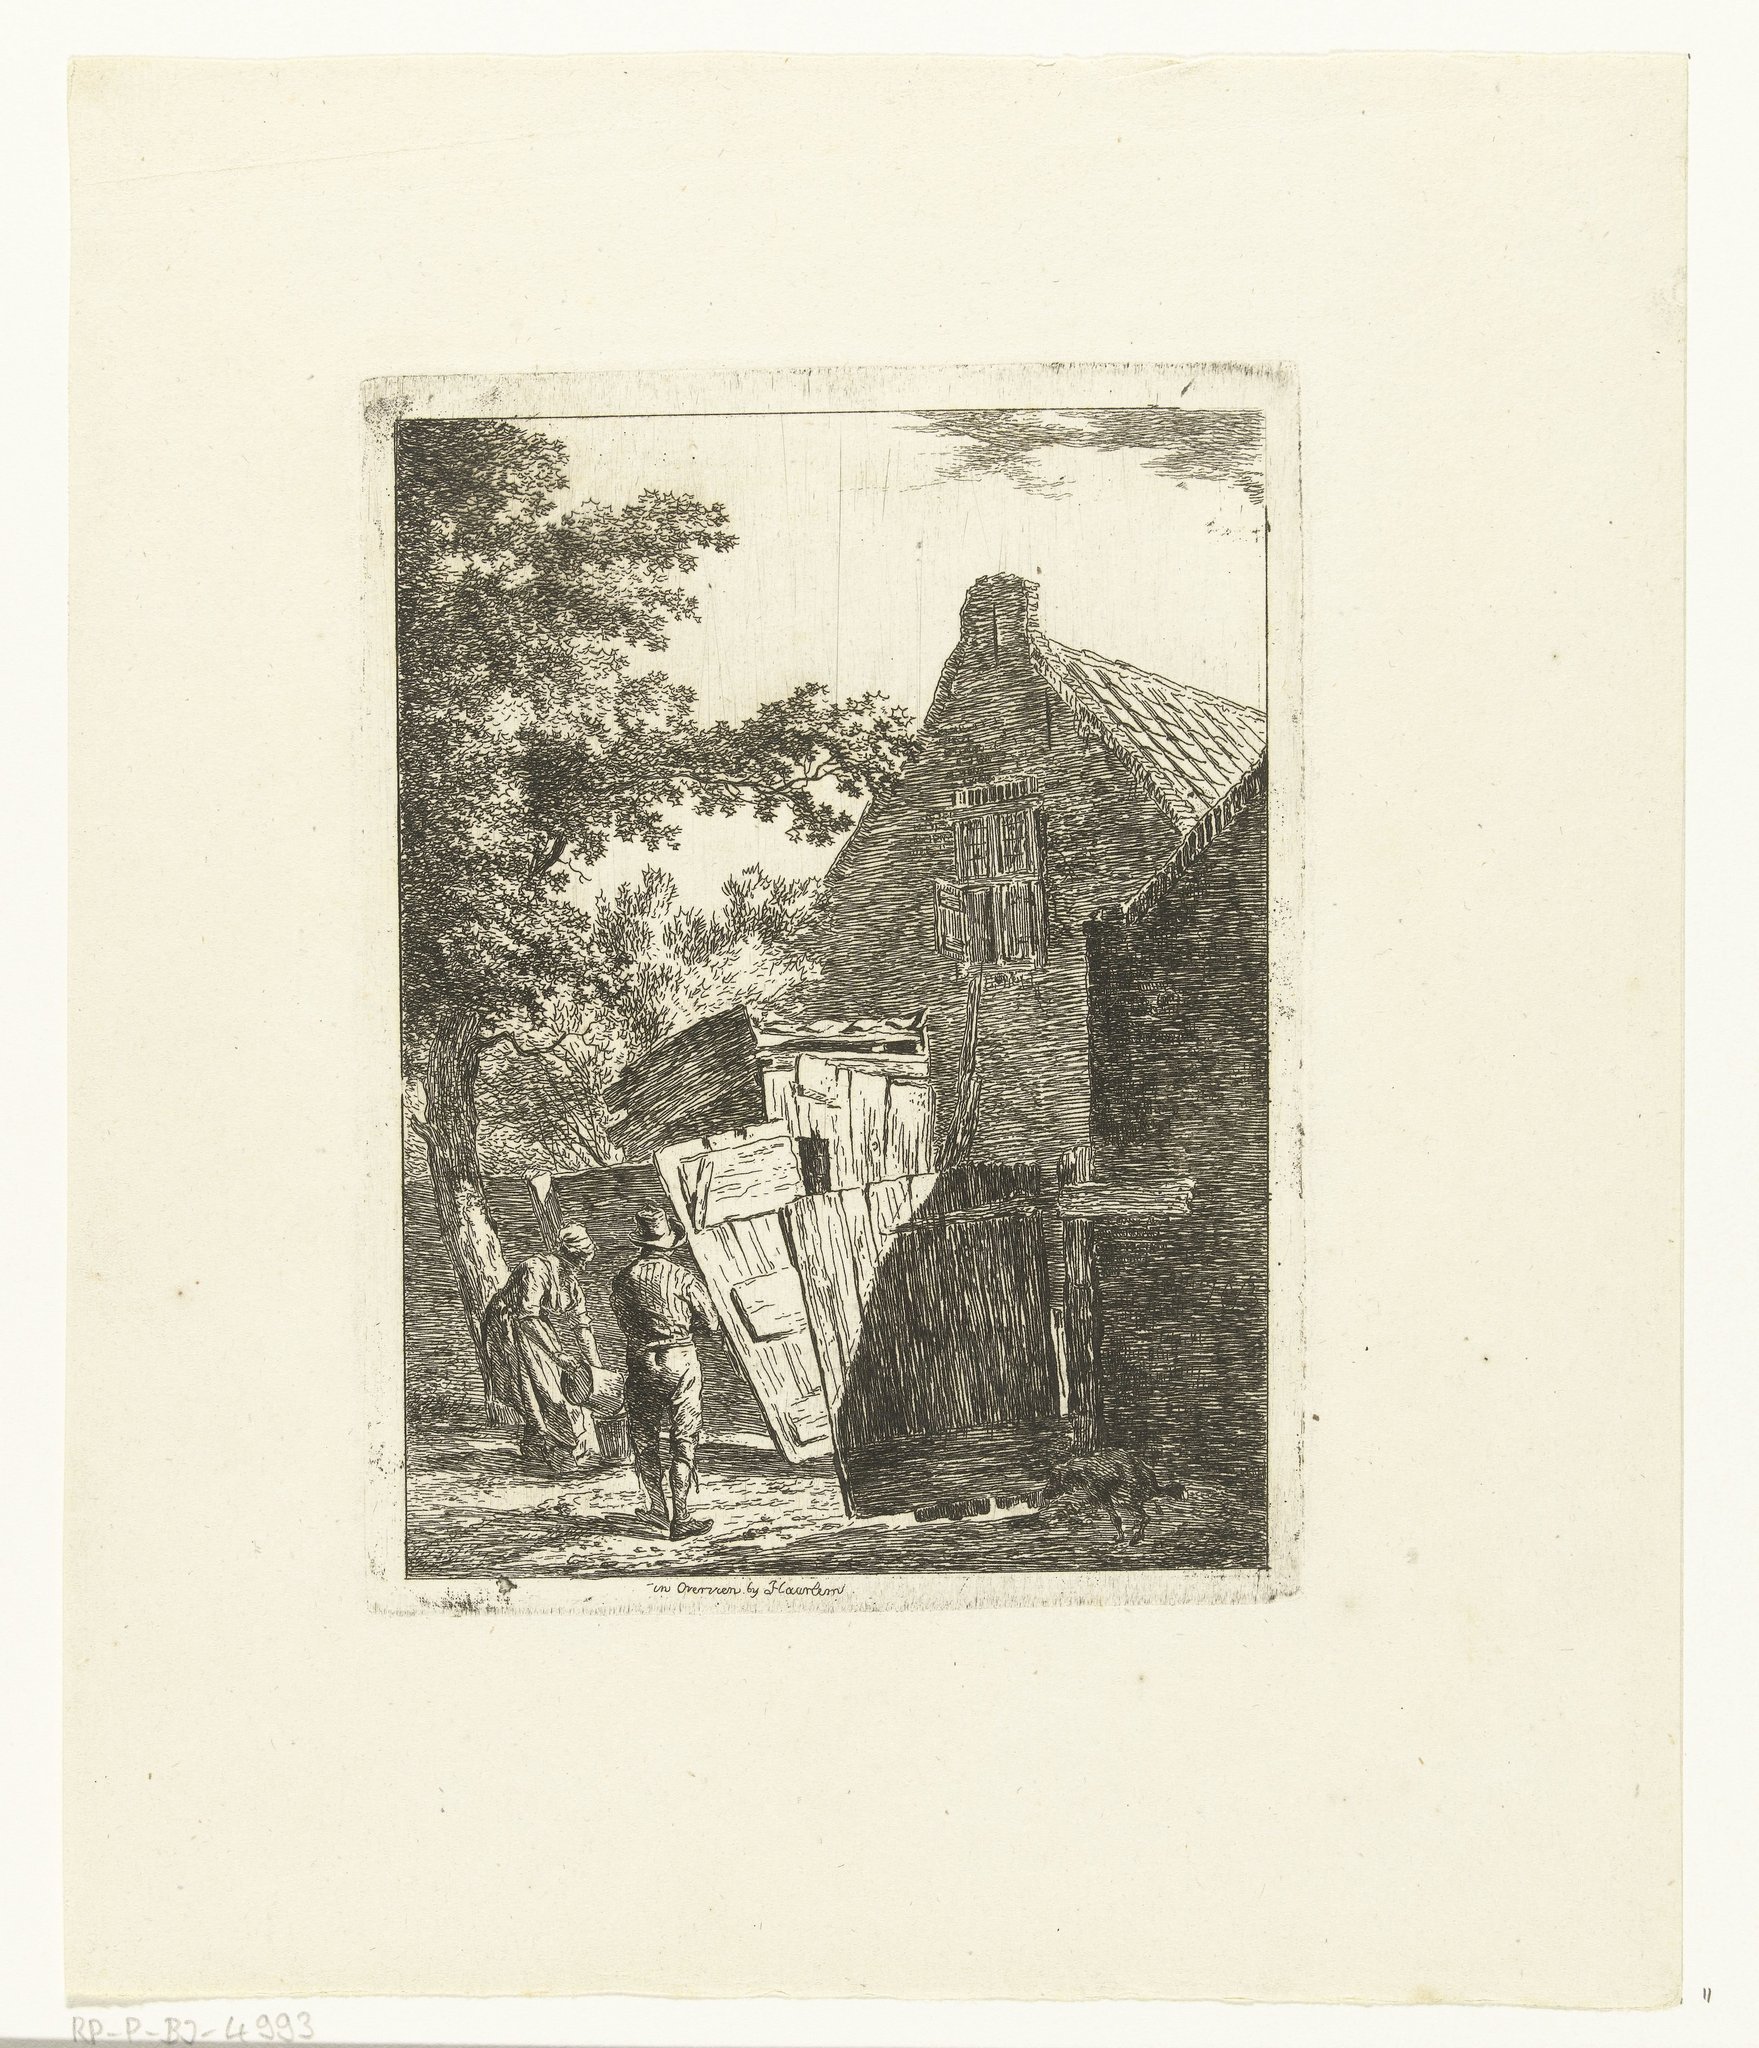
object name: print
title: In Overveen bij Haarlem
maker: hermanus van brussel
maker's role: draughtsman, print maker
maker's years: 1763-1815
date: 1800-1810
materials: paper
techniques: etching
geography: haarlem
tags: landscapes in the temperate zone, gate, entrance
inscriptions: collector's mark: Lugt 2228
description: Twee figuren voor een vervallen hek bij een huis.